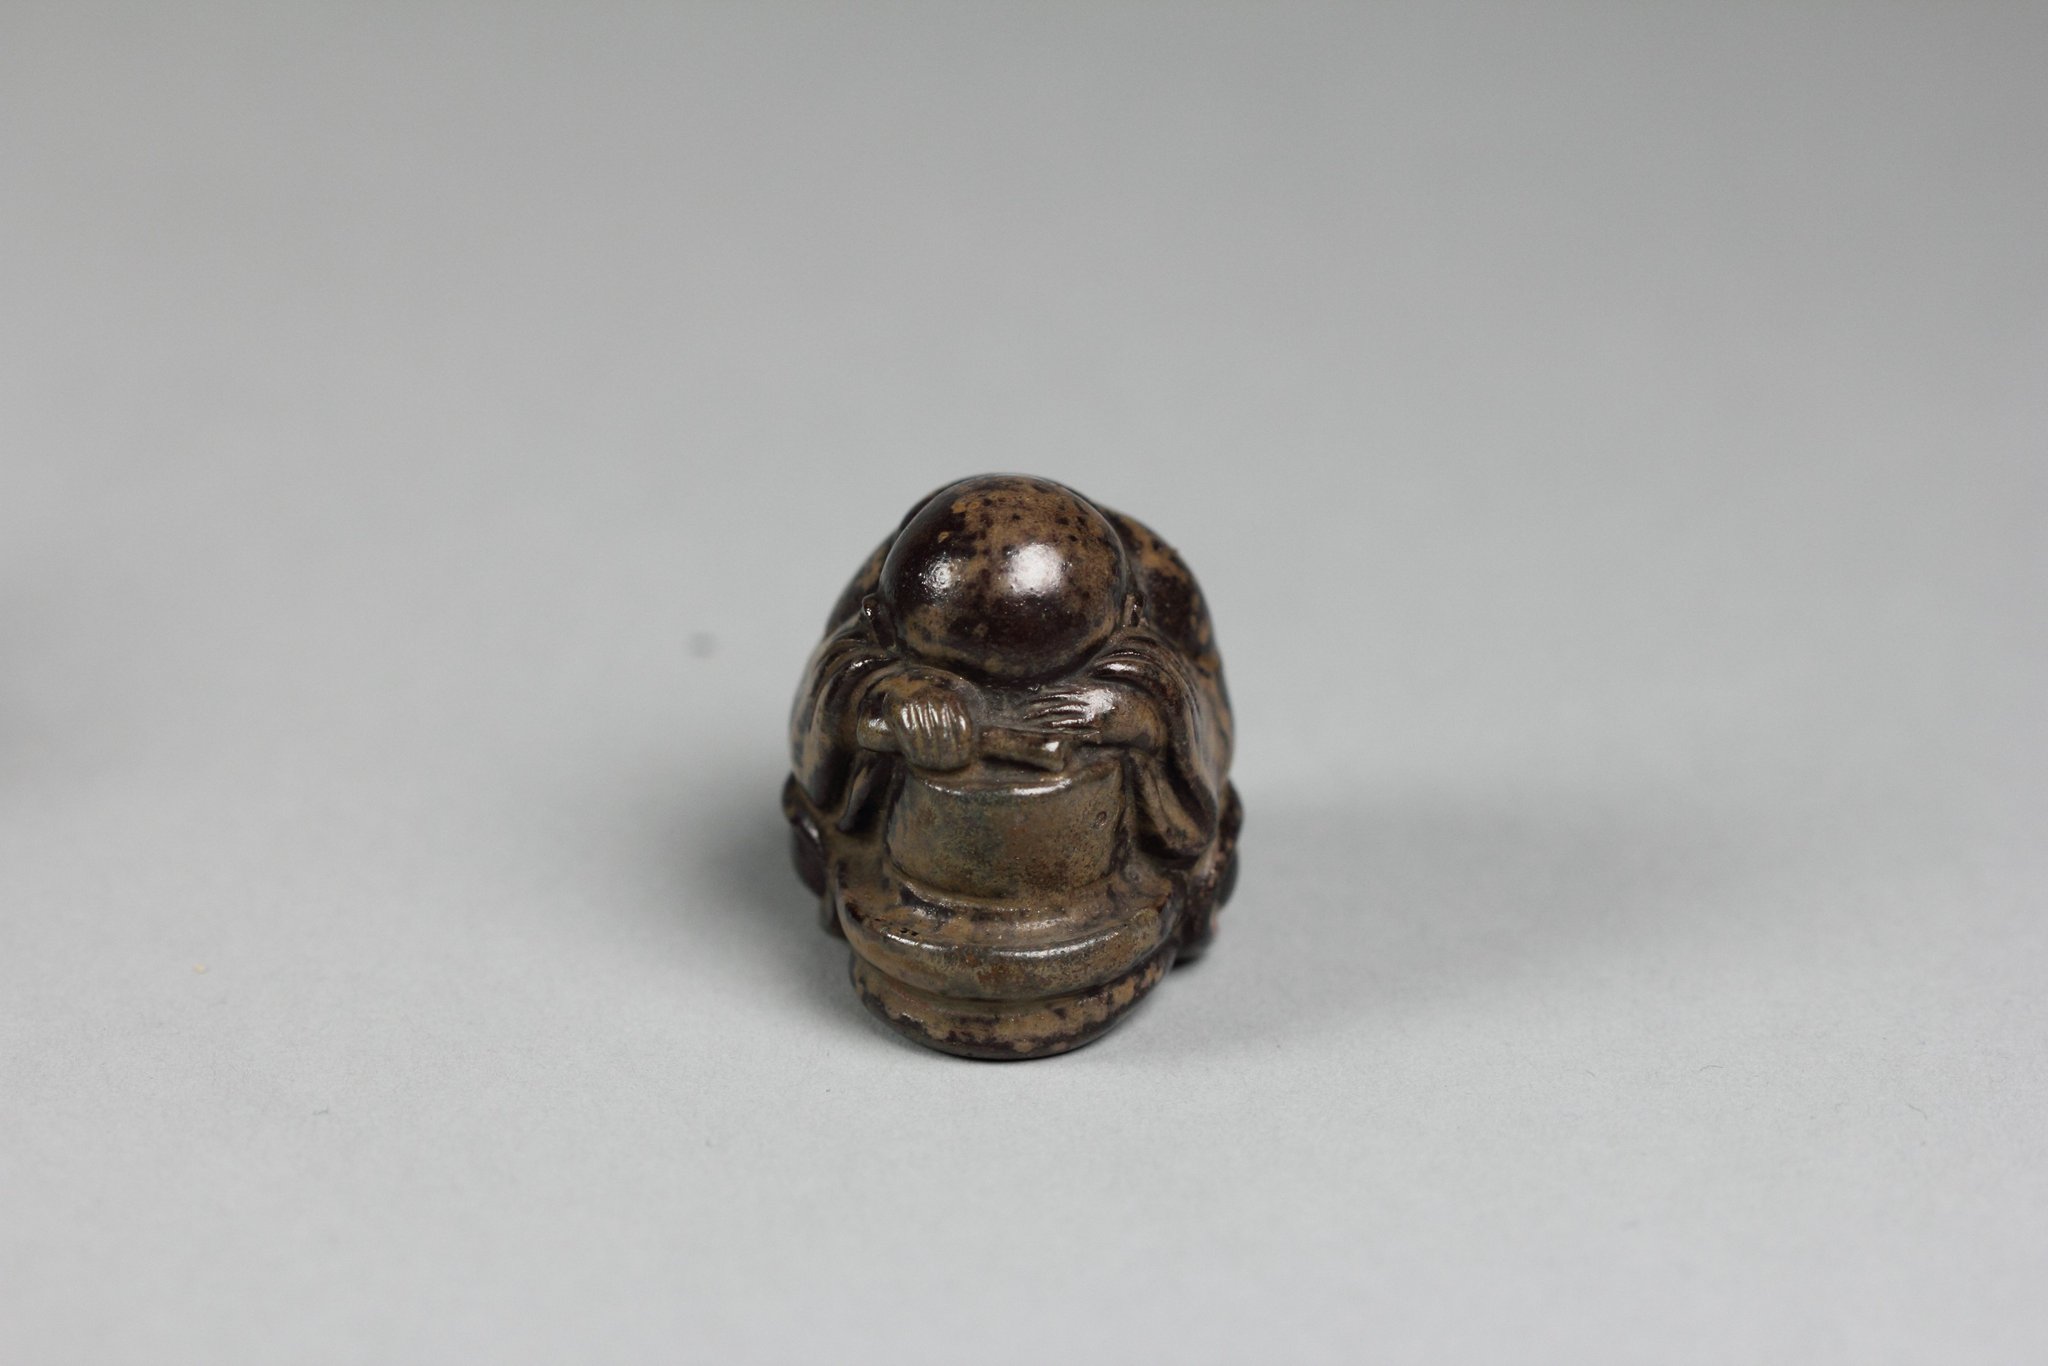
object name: netsuke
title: Netsuke of of a Priestling Asleep over a Stonemill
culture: japanese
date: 1701-1800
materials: glaze, pottery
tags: human figures,sleeping